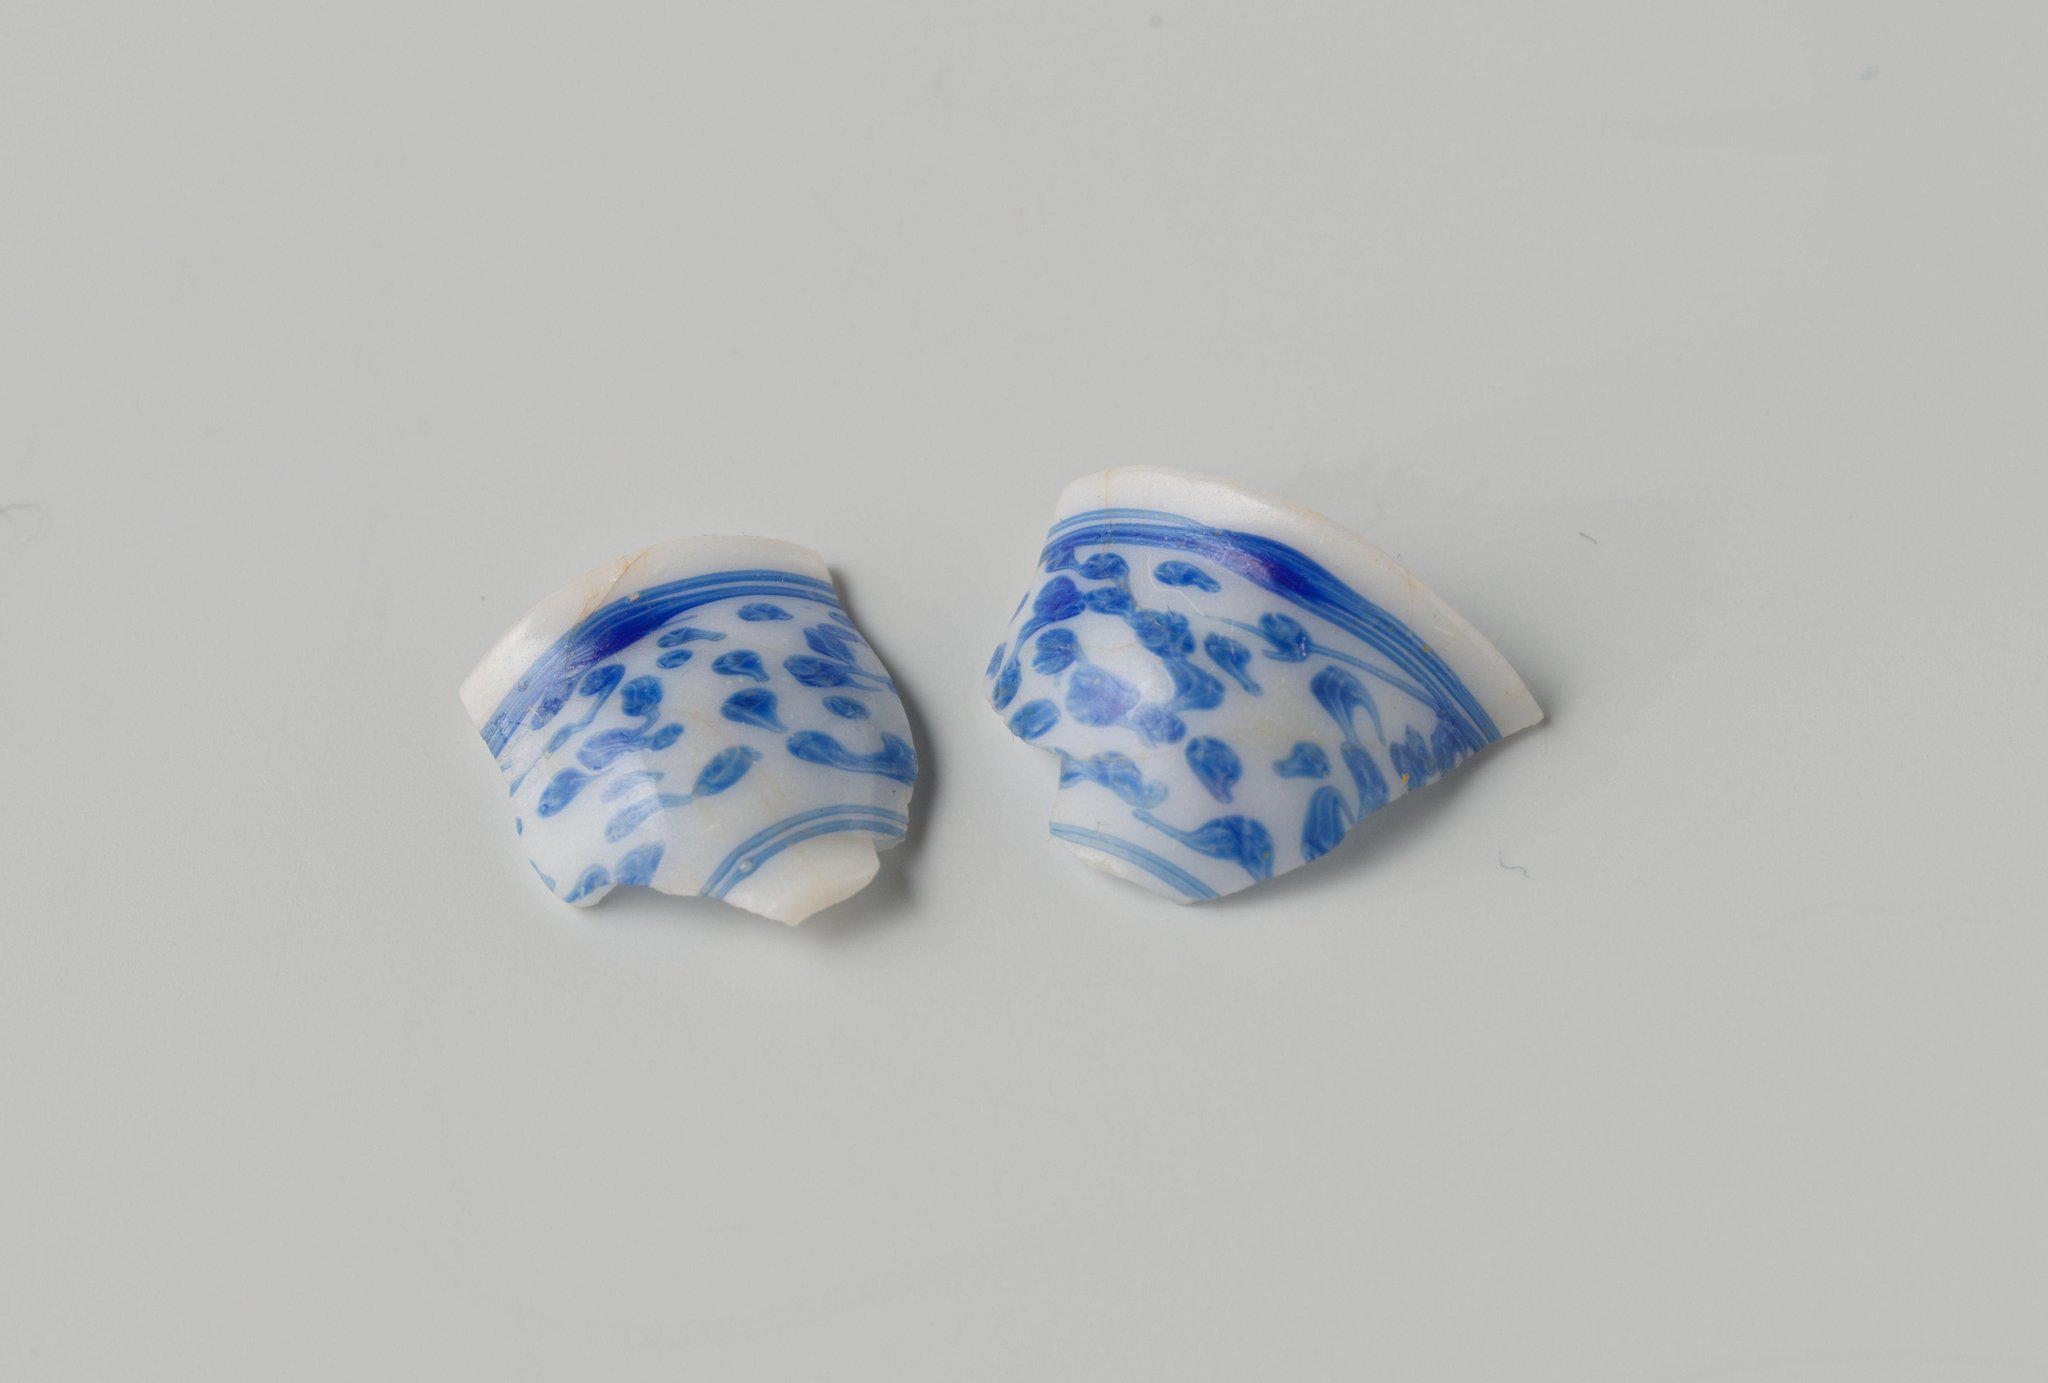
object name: cup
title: Deel (scherf) van kopje van melkglas met blauwe emailverf beschildering, imitatie Chinees porselein met doorlopende versiering van ranken; gladde mondrand.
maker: Anonymous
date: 1675-1710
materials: glass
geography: amsterdam